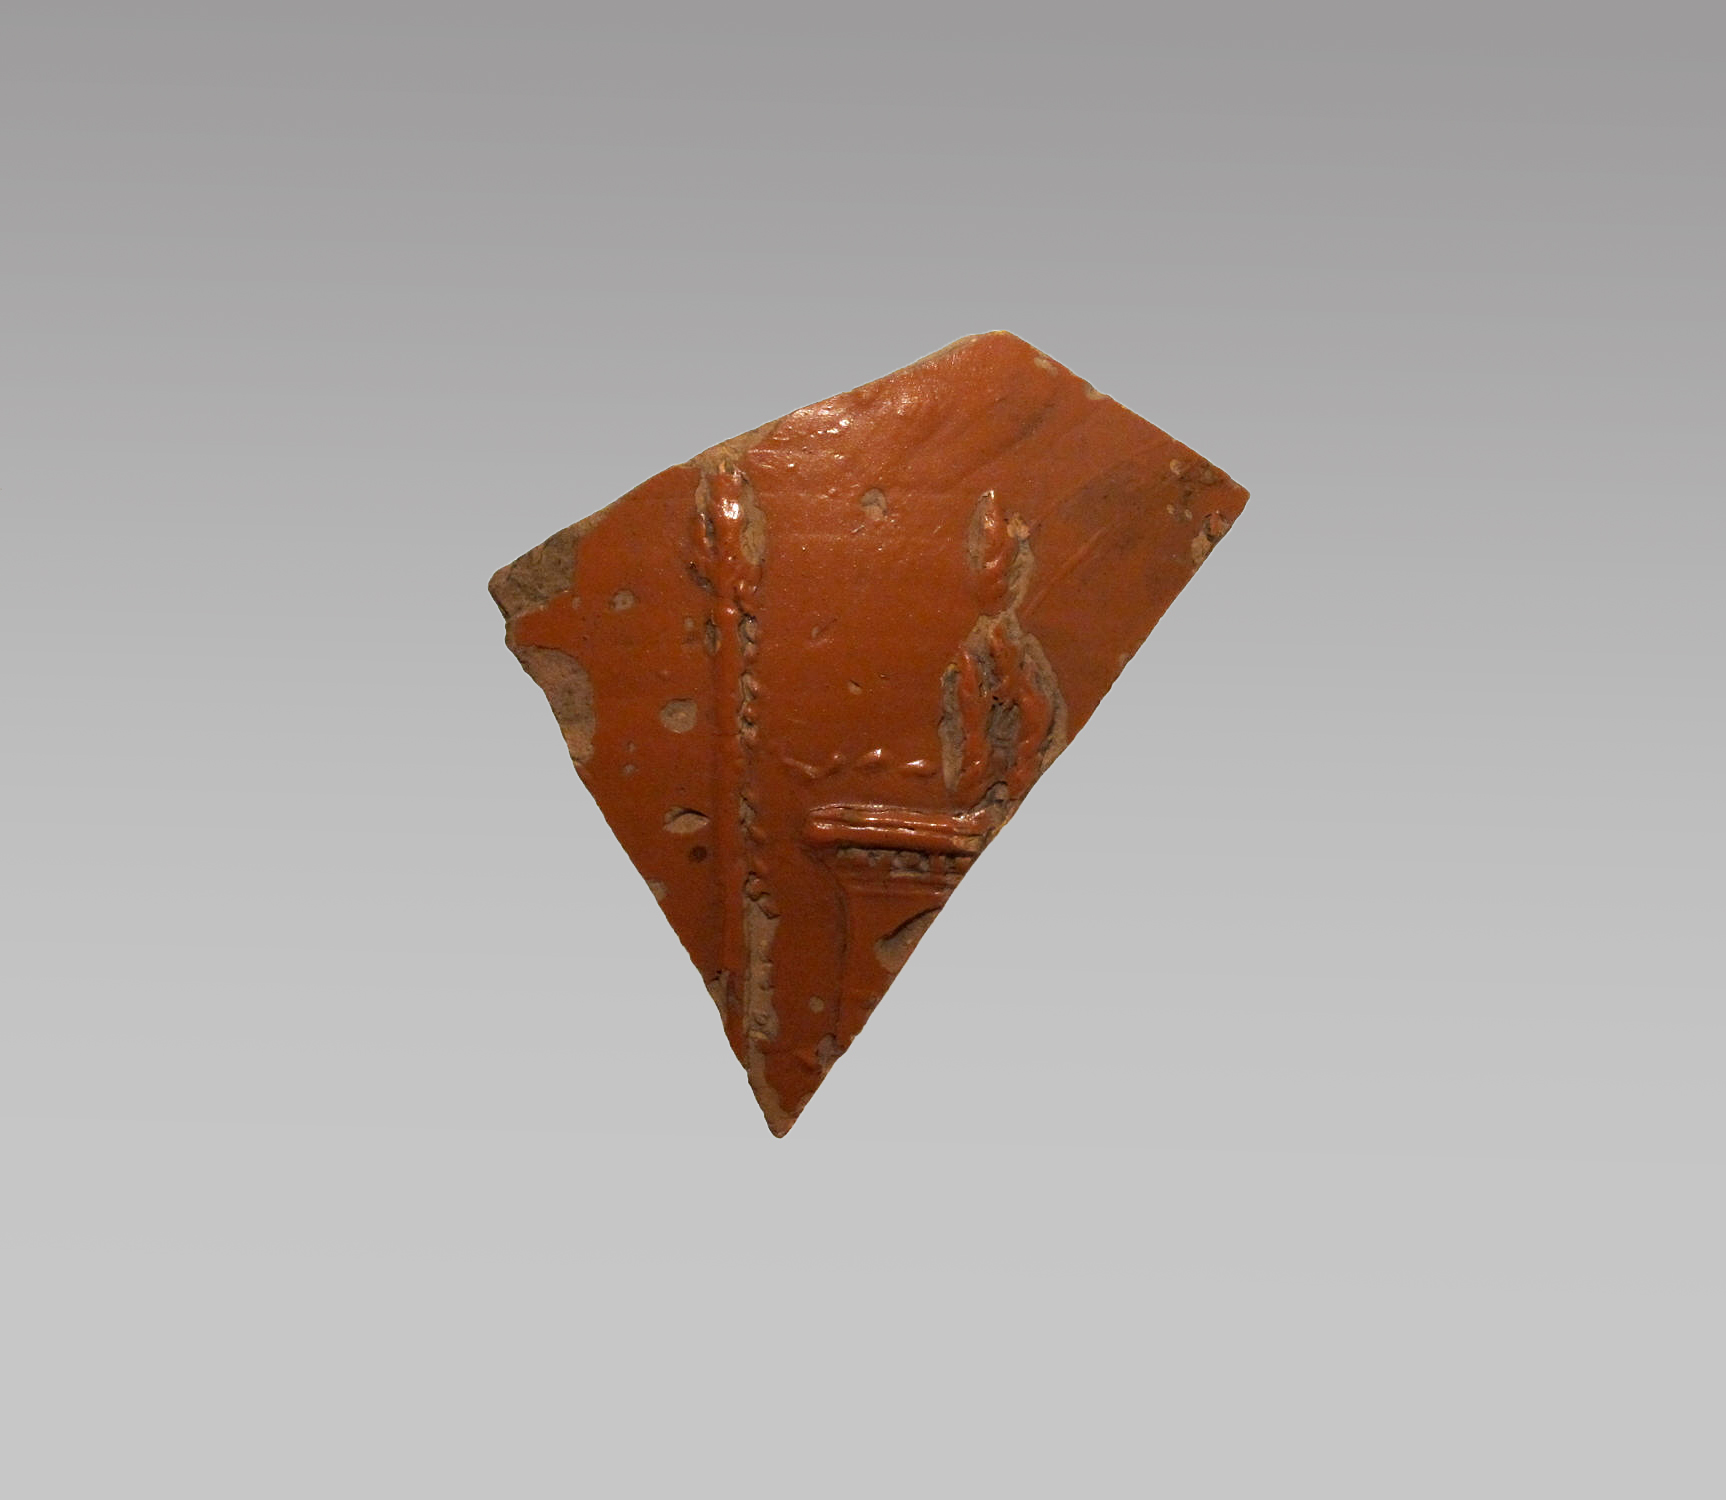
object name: vase fragment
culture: roman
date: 670 BCE-330 CE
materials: terracotta